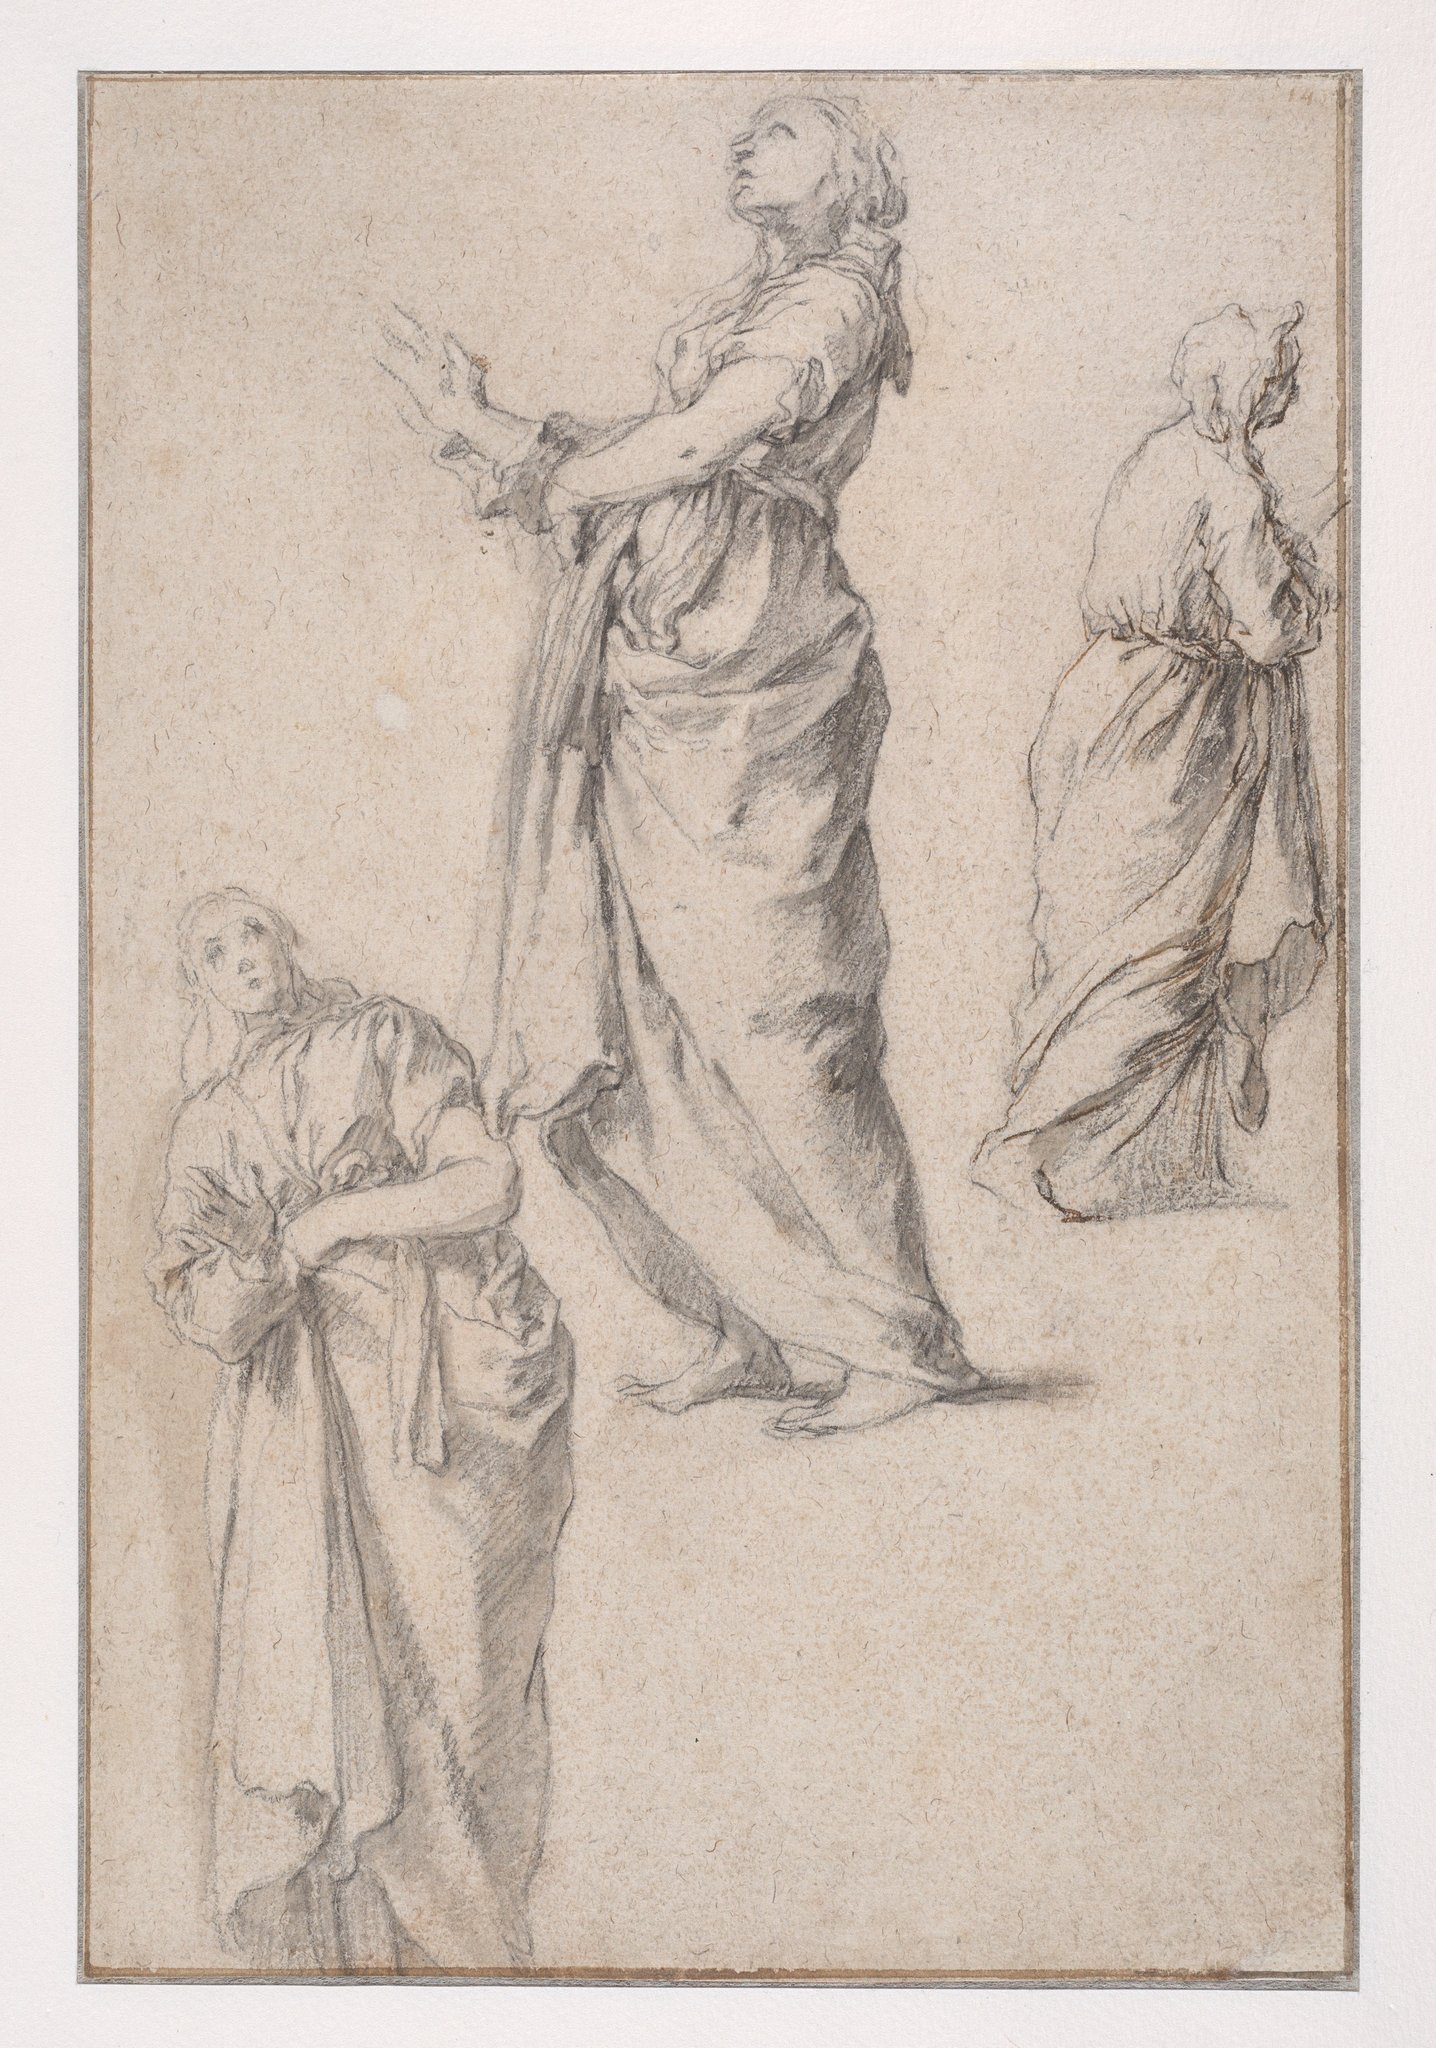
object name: drawing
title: Three Studies of a Woman (recto); Woman from the Back, Study of Legs (verso)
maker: abraham bloemaert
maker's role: artist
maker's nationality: netherlandish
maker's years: 1566-1651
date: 1620-1625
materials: chalk, ink, paper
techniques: brush, printmaking, heightening, pen, wash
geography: netherlands